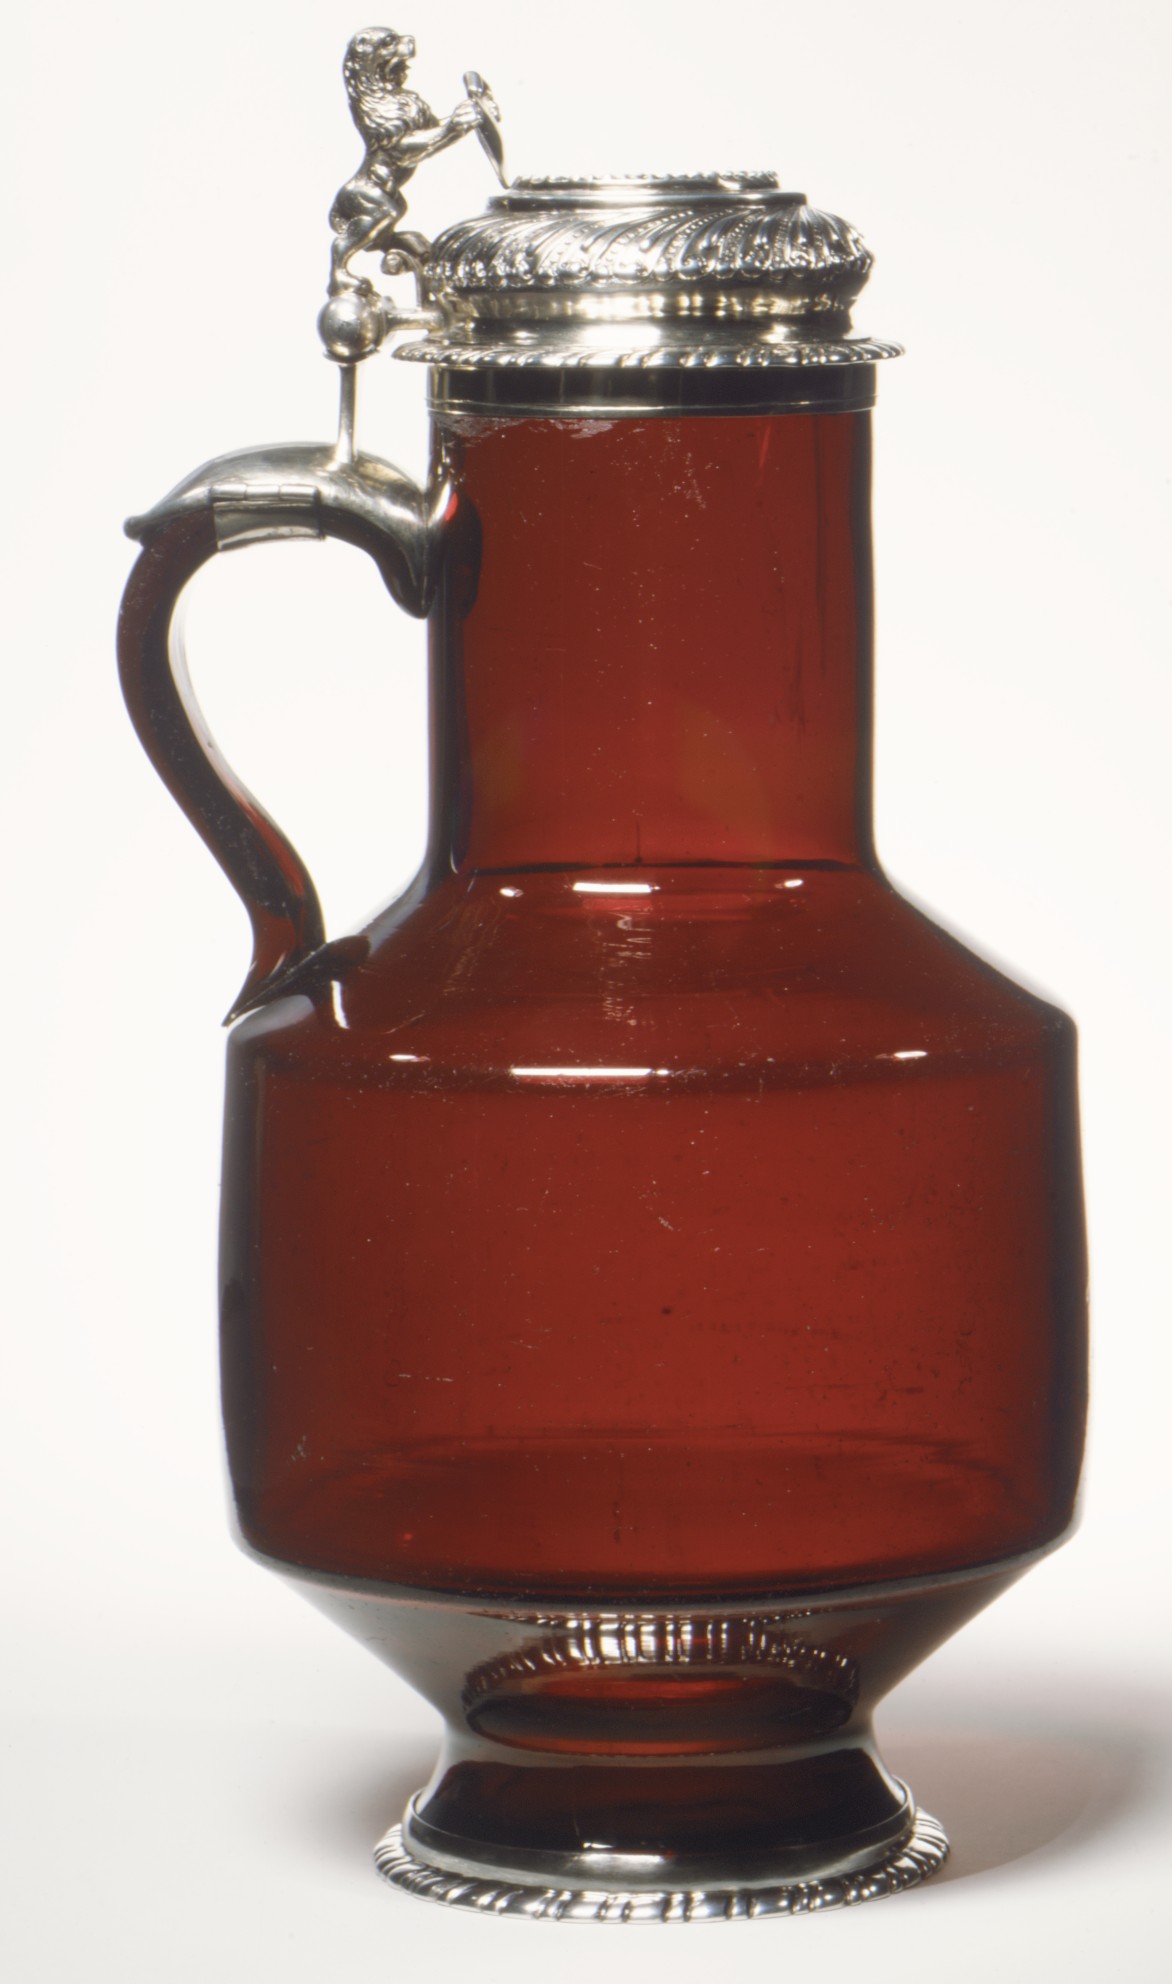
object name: flagon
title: Flagon with medal of John Huss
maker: michael hohenauer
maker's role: artist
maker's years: 1500-1560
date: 1801-1900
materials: glass, silver gilt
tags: lions